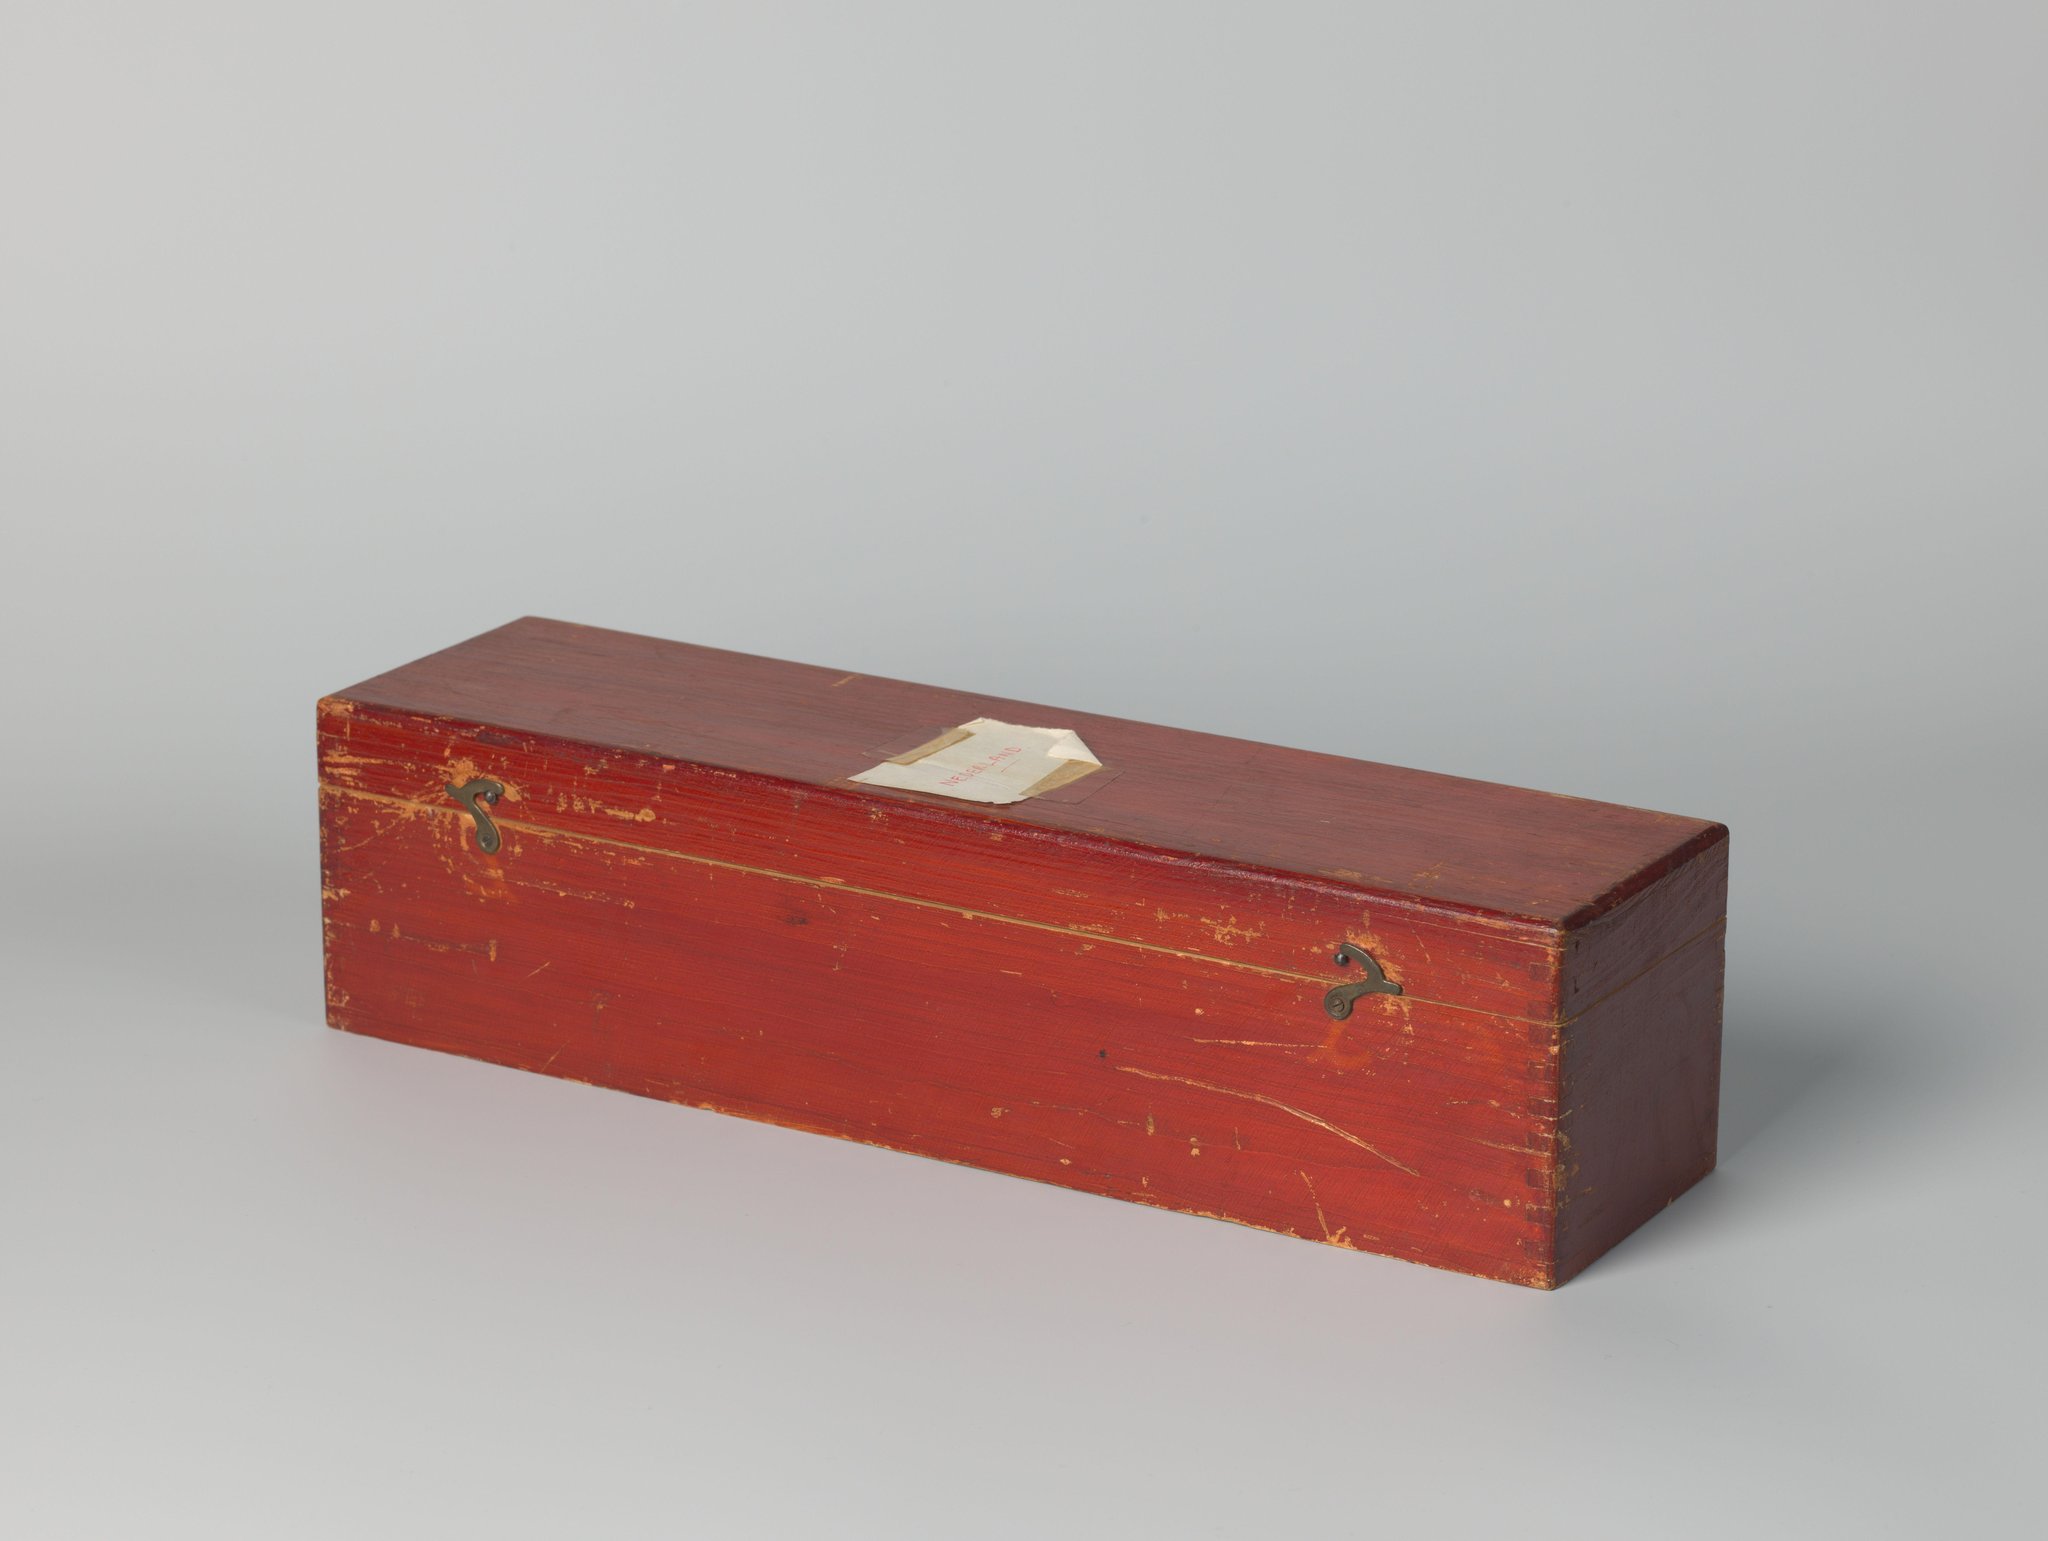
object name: chest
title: Lege houten kist voor 48 fotografische lantaarnplaatjes van de familie Kessler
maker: geldolph adriaan kessler (dolph)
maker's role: fotograaf, industrieel, voetballer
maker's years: 1884-1945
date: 1900-1910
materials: wood